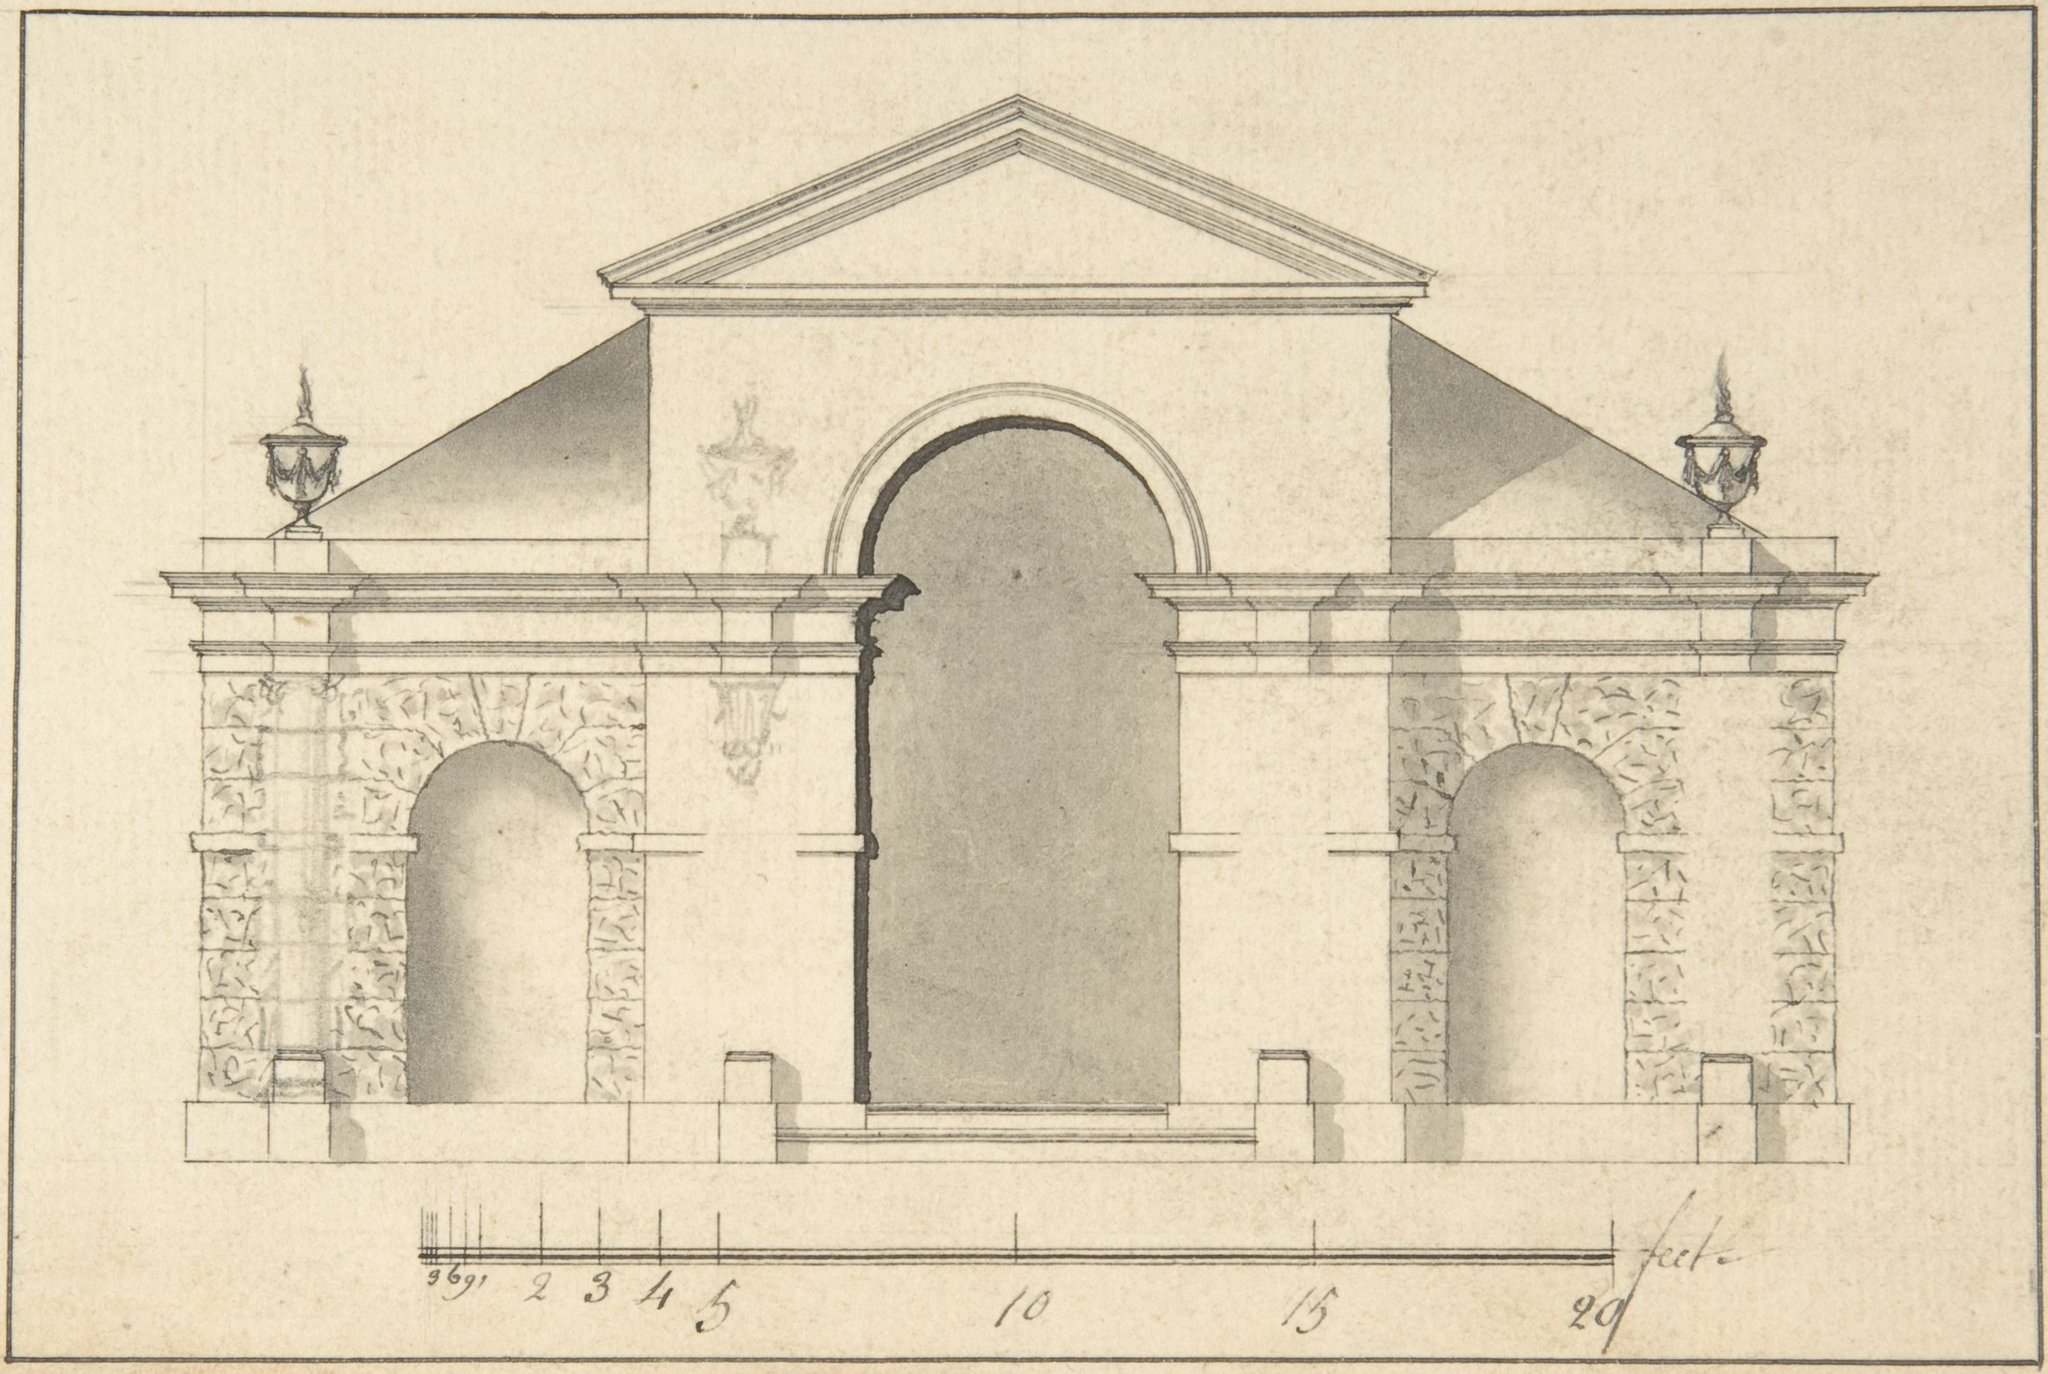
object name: drawing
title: Elevation of Garden Pavilion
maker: robert morris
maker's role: artist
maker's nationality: british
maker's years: 1701-1754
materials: graphite, ink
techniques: brush, pen, wash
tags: architecture,pavilions